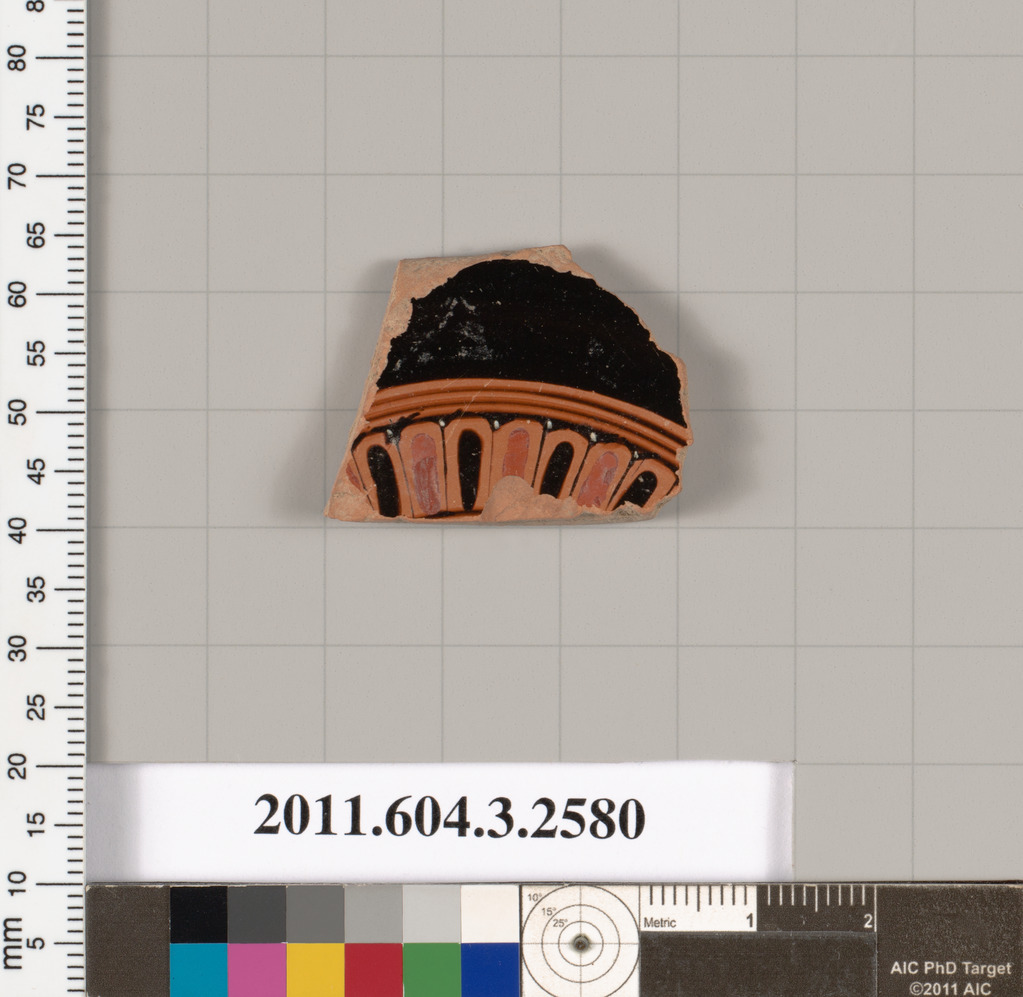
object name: kylix fragment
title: Terracotta fragment of a Little Master cup (drinking cup)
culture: greek, attic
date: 575-551 BCE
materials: terracotta